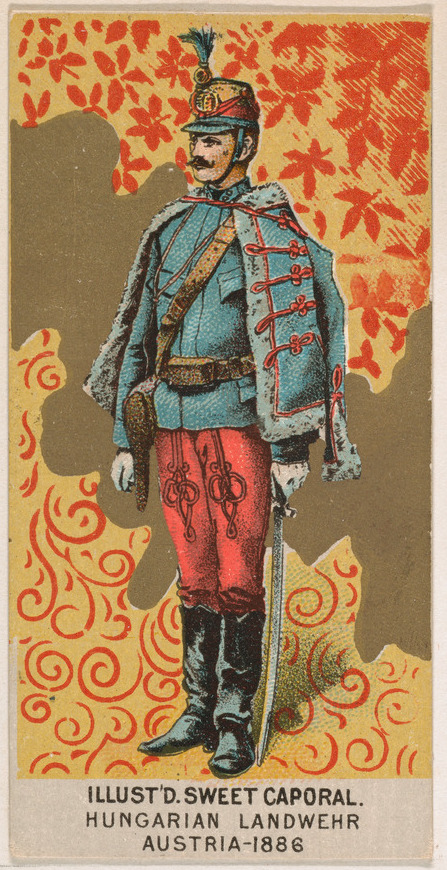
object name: print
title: Hungarian Landwehr, Austria, 1886, from the Military Series (N224) issued by Kinney Tobacco Company to promote Sweet Caporal Cigarettes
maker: kinney brothers tobacco company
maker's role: publisher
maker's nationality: american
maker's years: 1869-2011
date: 1888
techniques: color lithograph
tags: military,soldiers,swords,men